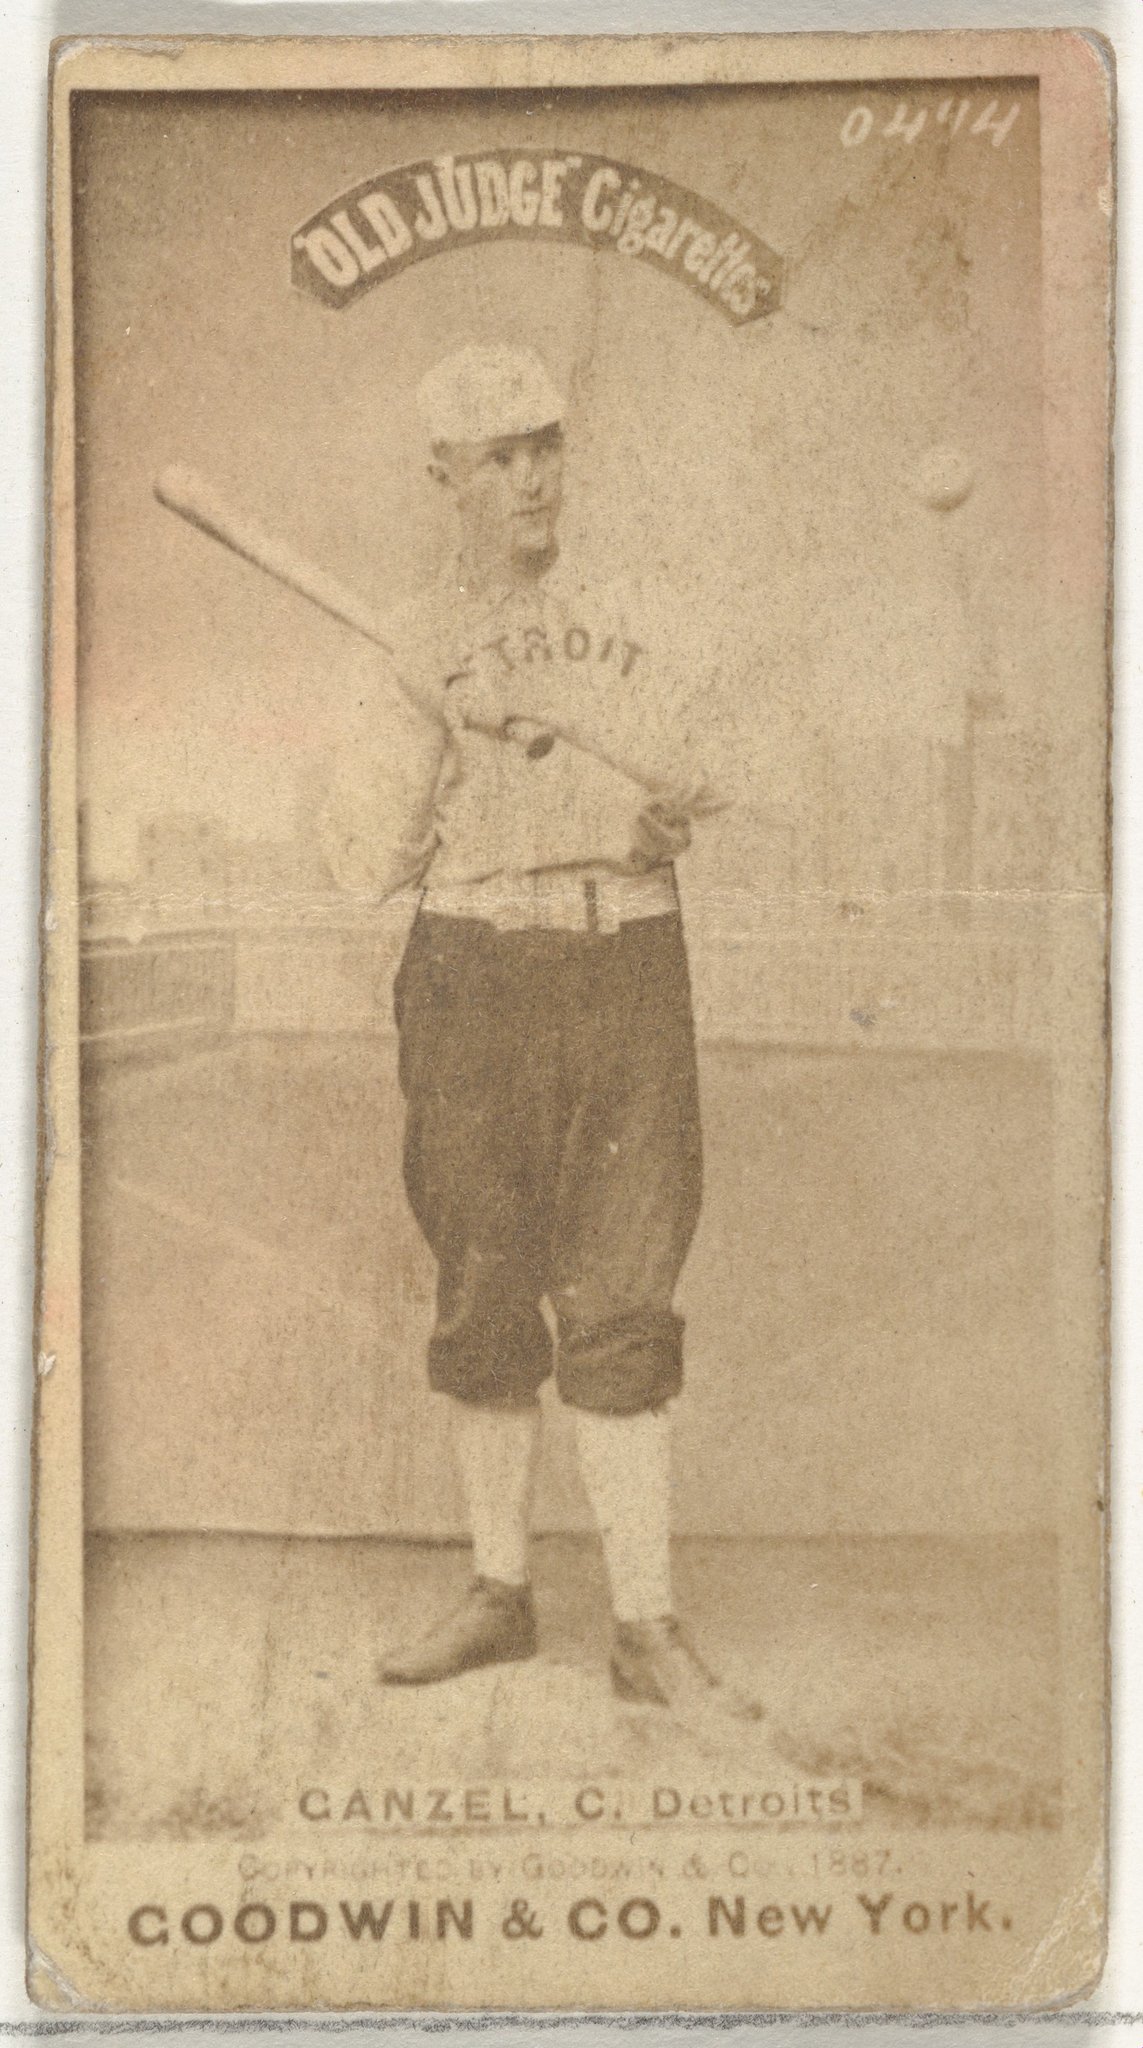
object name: baseball card, photograph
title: Charles William "Charlie" Ganzel, Catcher, Detroit Wolverines, from the Old Judge series (N172) for Old Judge Cigarettes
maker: goodwin & company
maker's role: publisher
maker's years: 1850-1950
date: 1887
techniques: albumen silver print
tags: men,portraits,baseball,athletes